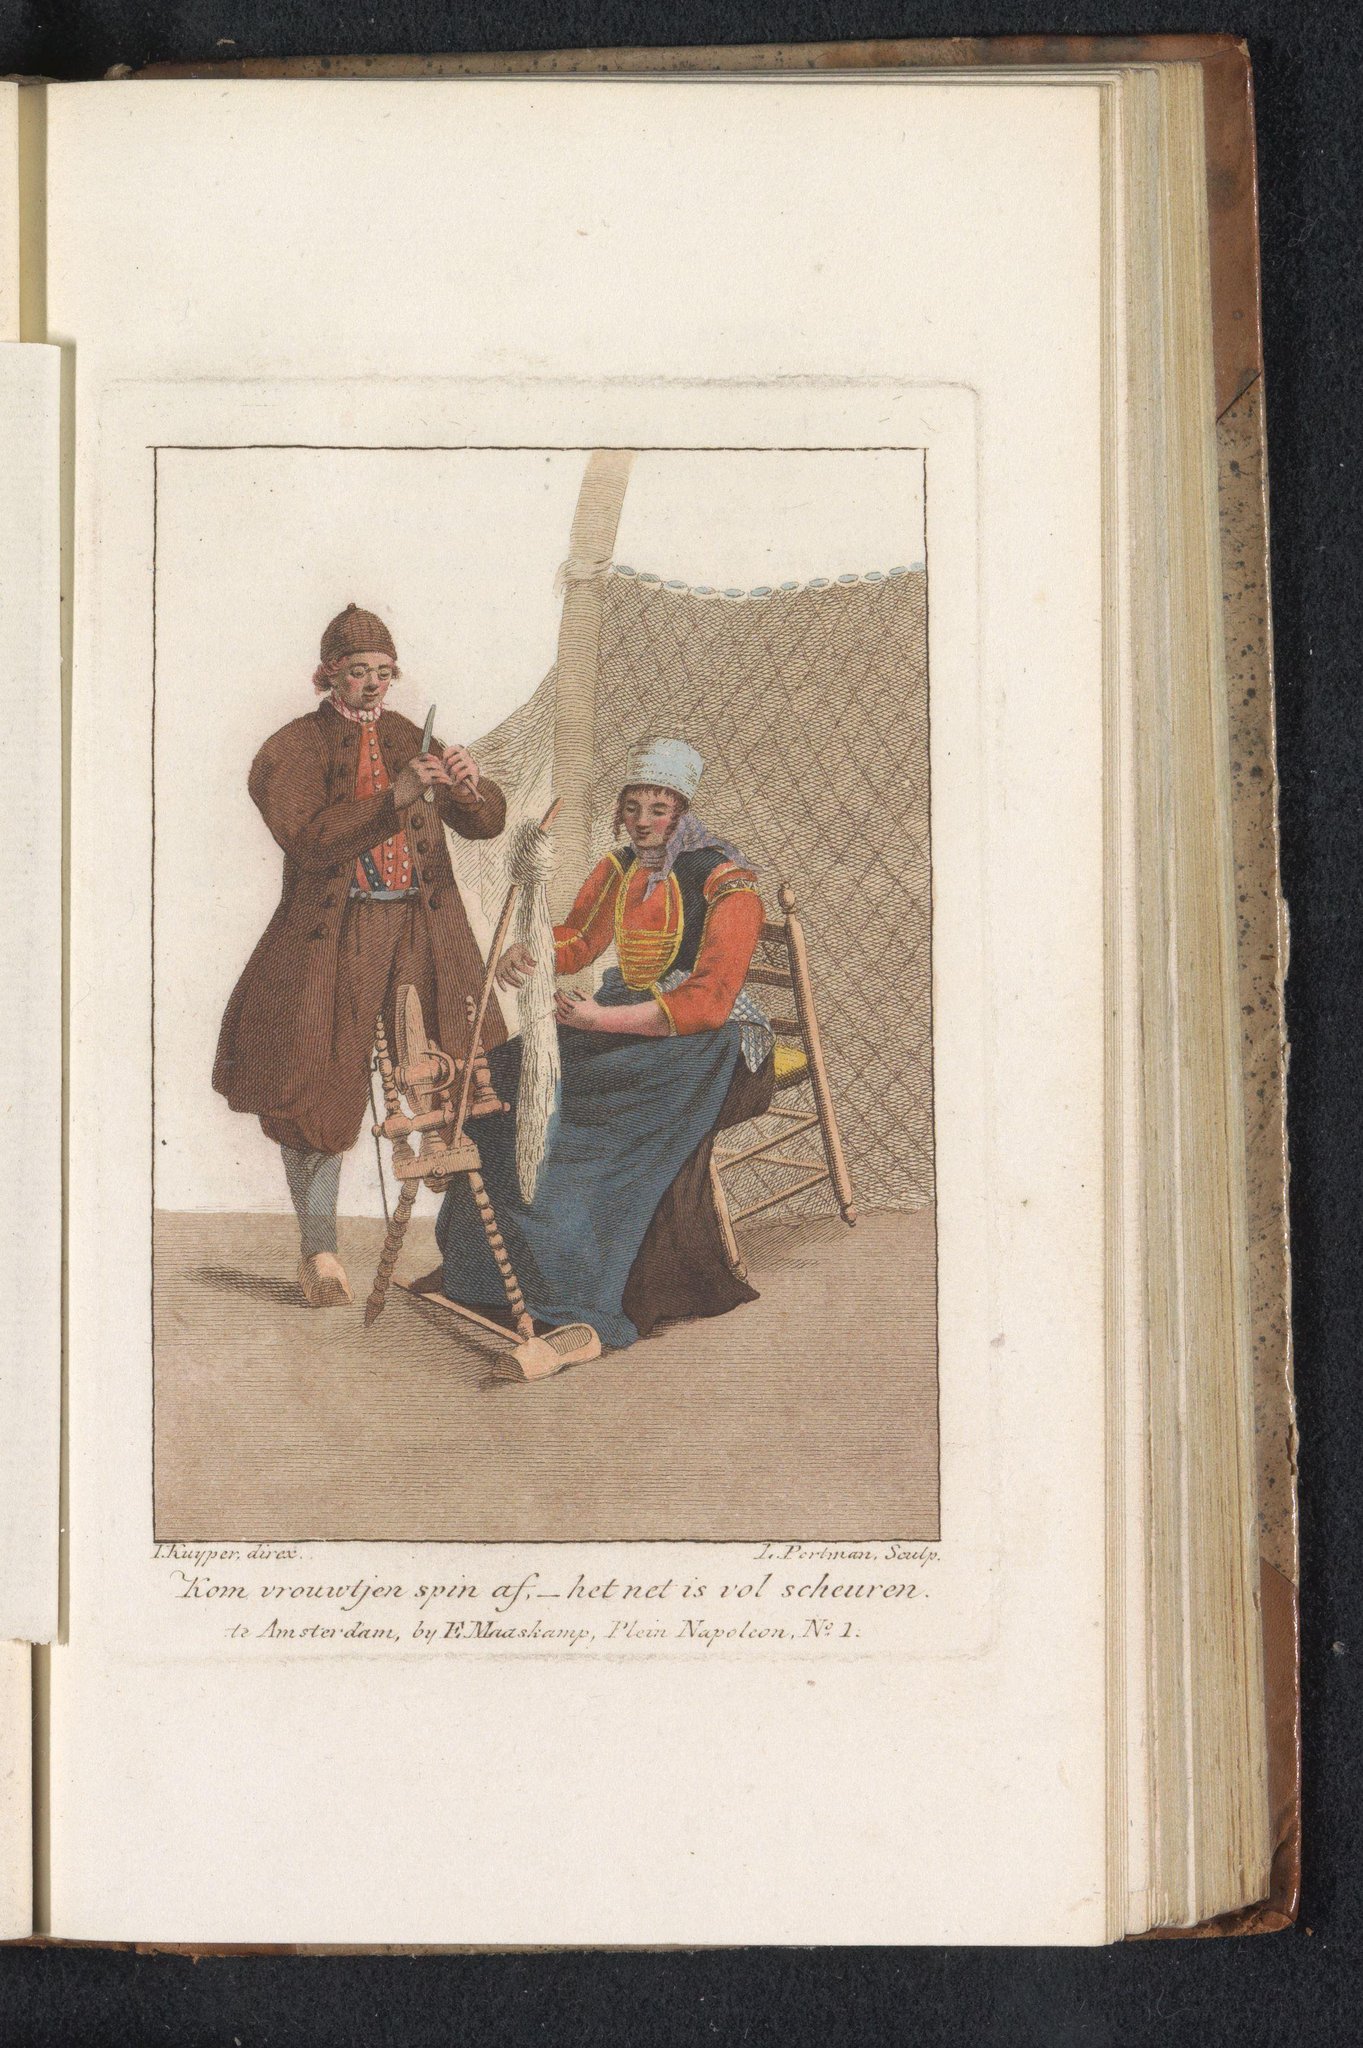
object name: book illustration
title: Vissersechtpaar uit Schokland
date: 1812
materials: paper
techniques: etching, hand coloring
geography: netherlands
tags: folk costume, regional costume, clothes, costume, spinning (manufacture of yarn), fisherman, mending of fishing nets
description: Een vissersvrouw uit Schokland zit achter het spinnewiel draad te spinnen waarmee haar man zijn visnet kan boeten. Onderdeel van de verkleinde kopieën uit 1812 naar de platen van Nederlandse klederdrachten uit de jaren 1803-1807.